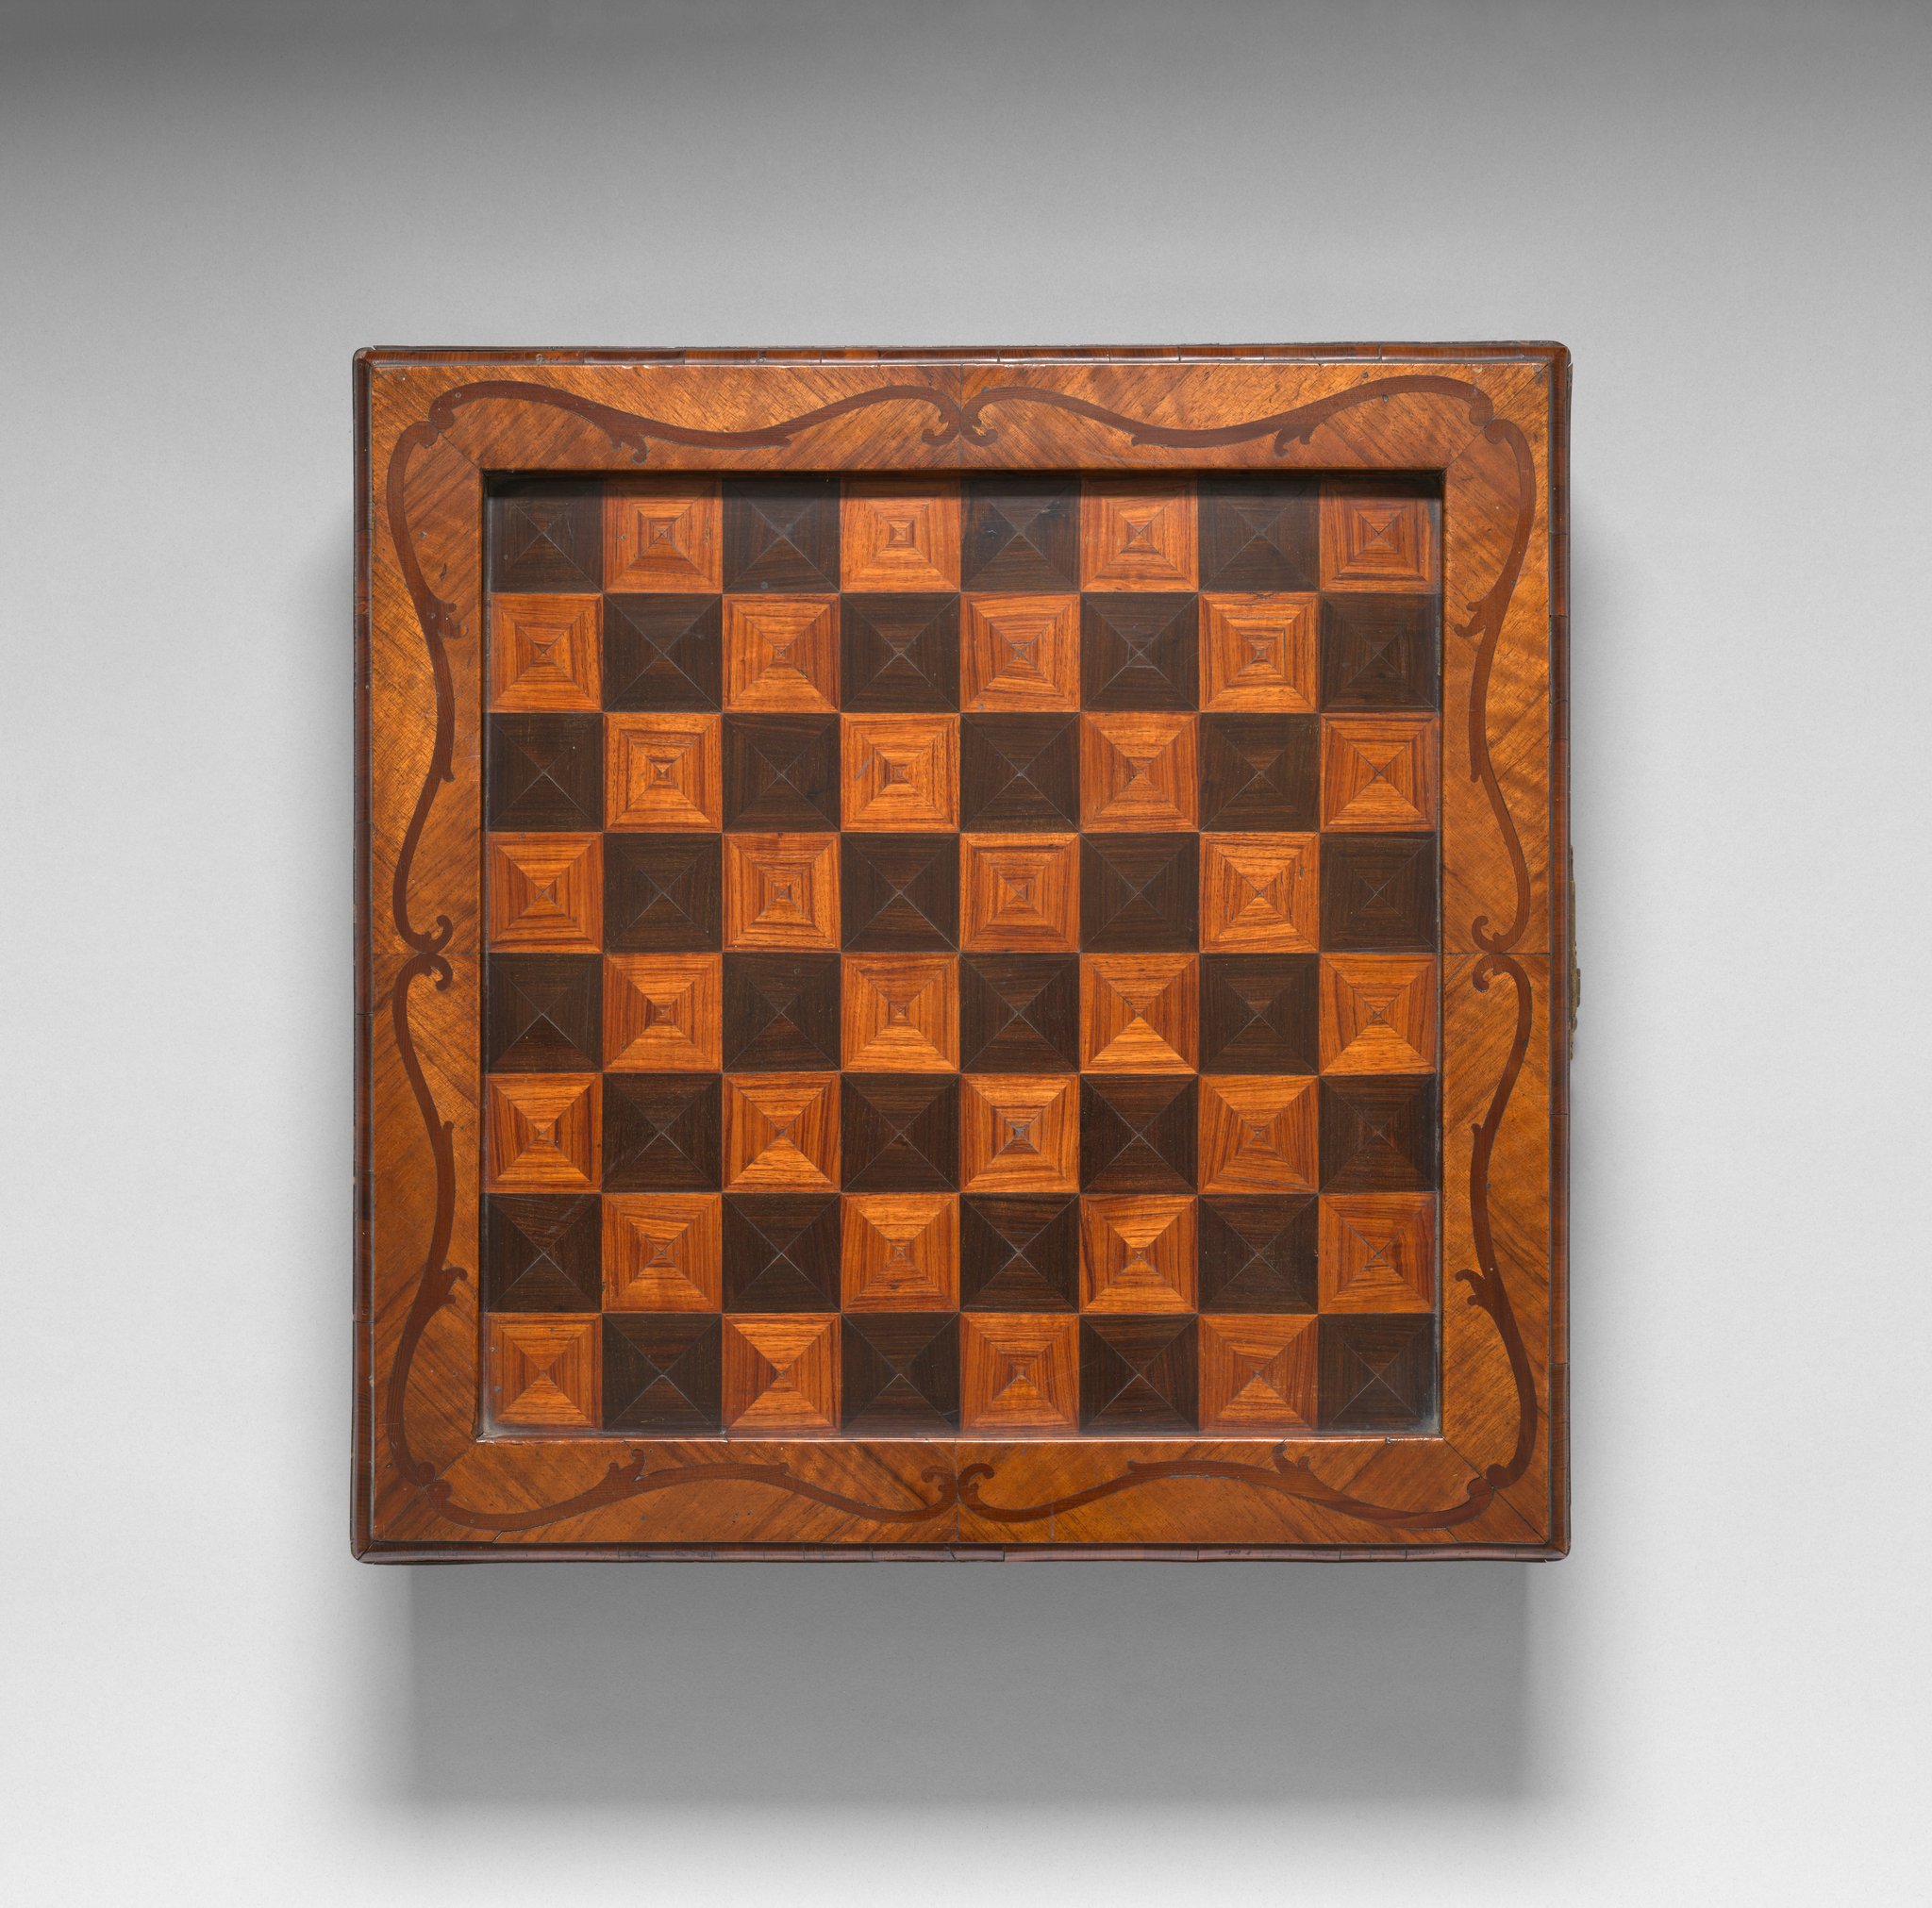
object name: chess and backgammon board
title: Box-board for chess and backgammon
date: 1801-1900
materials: wood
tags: chess